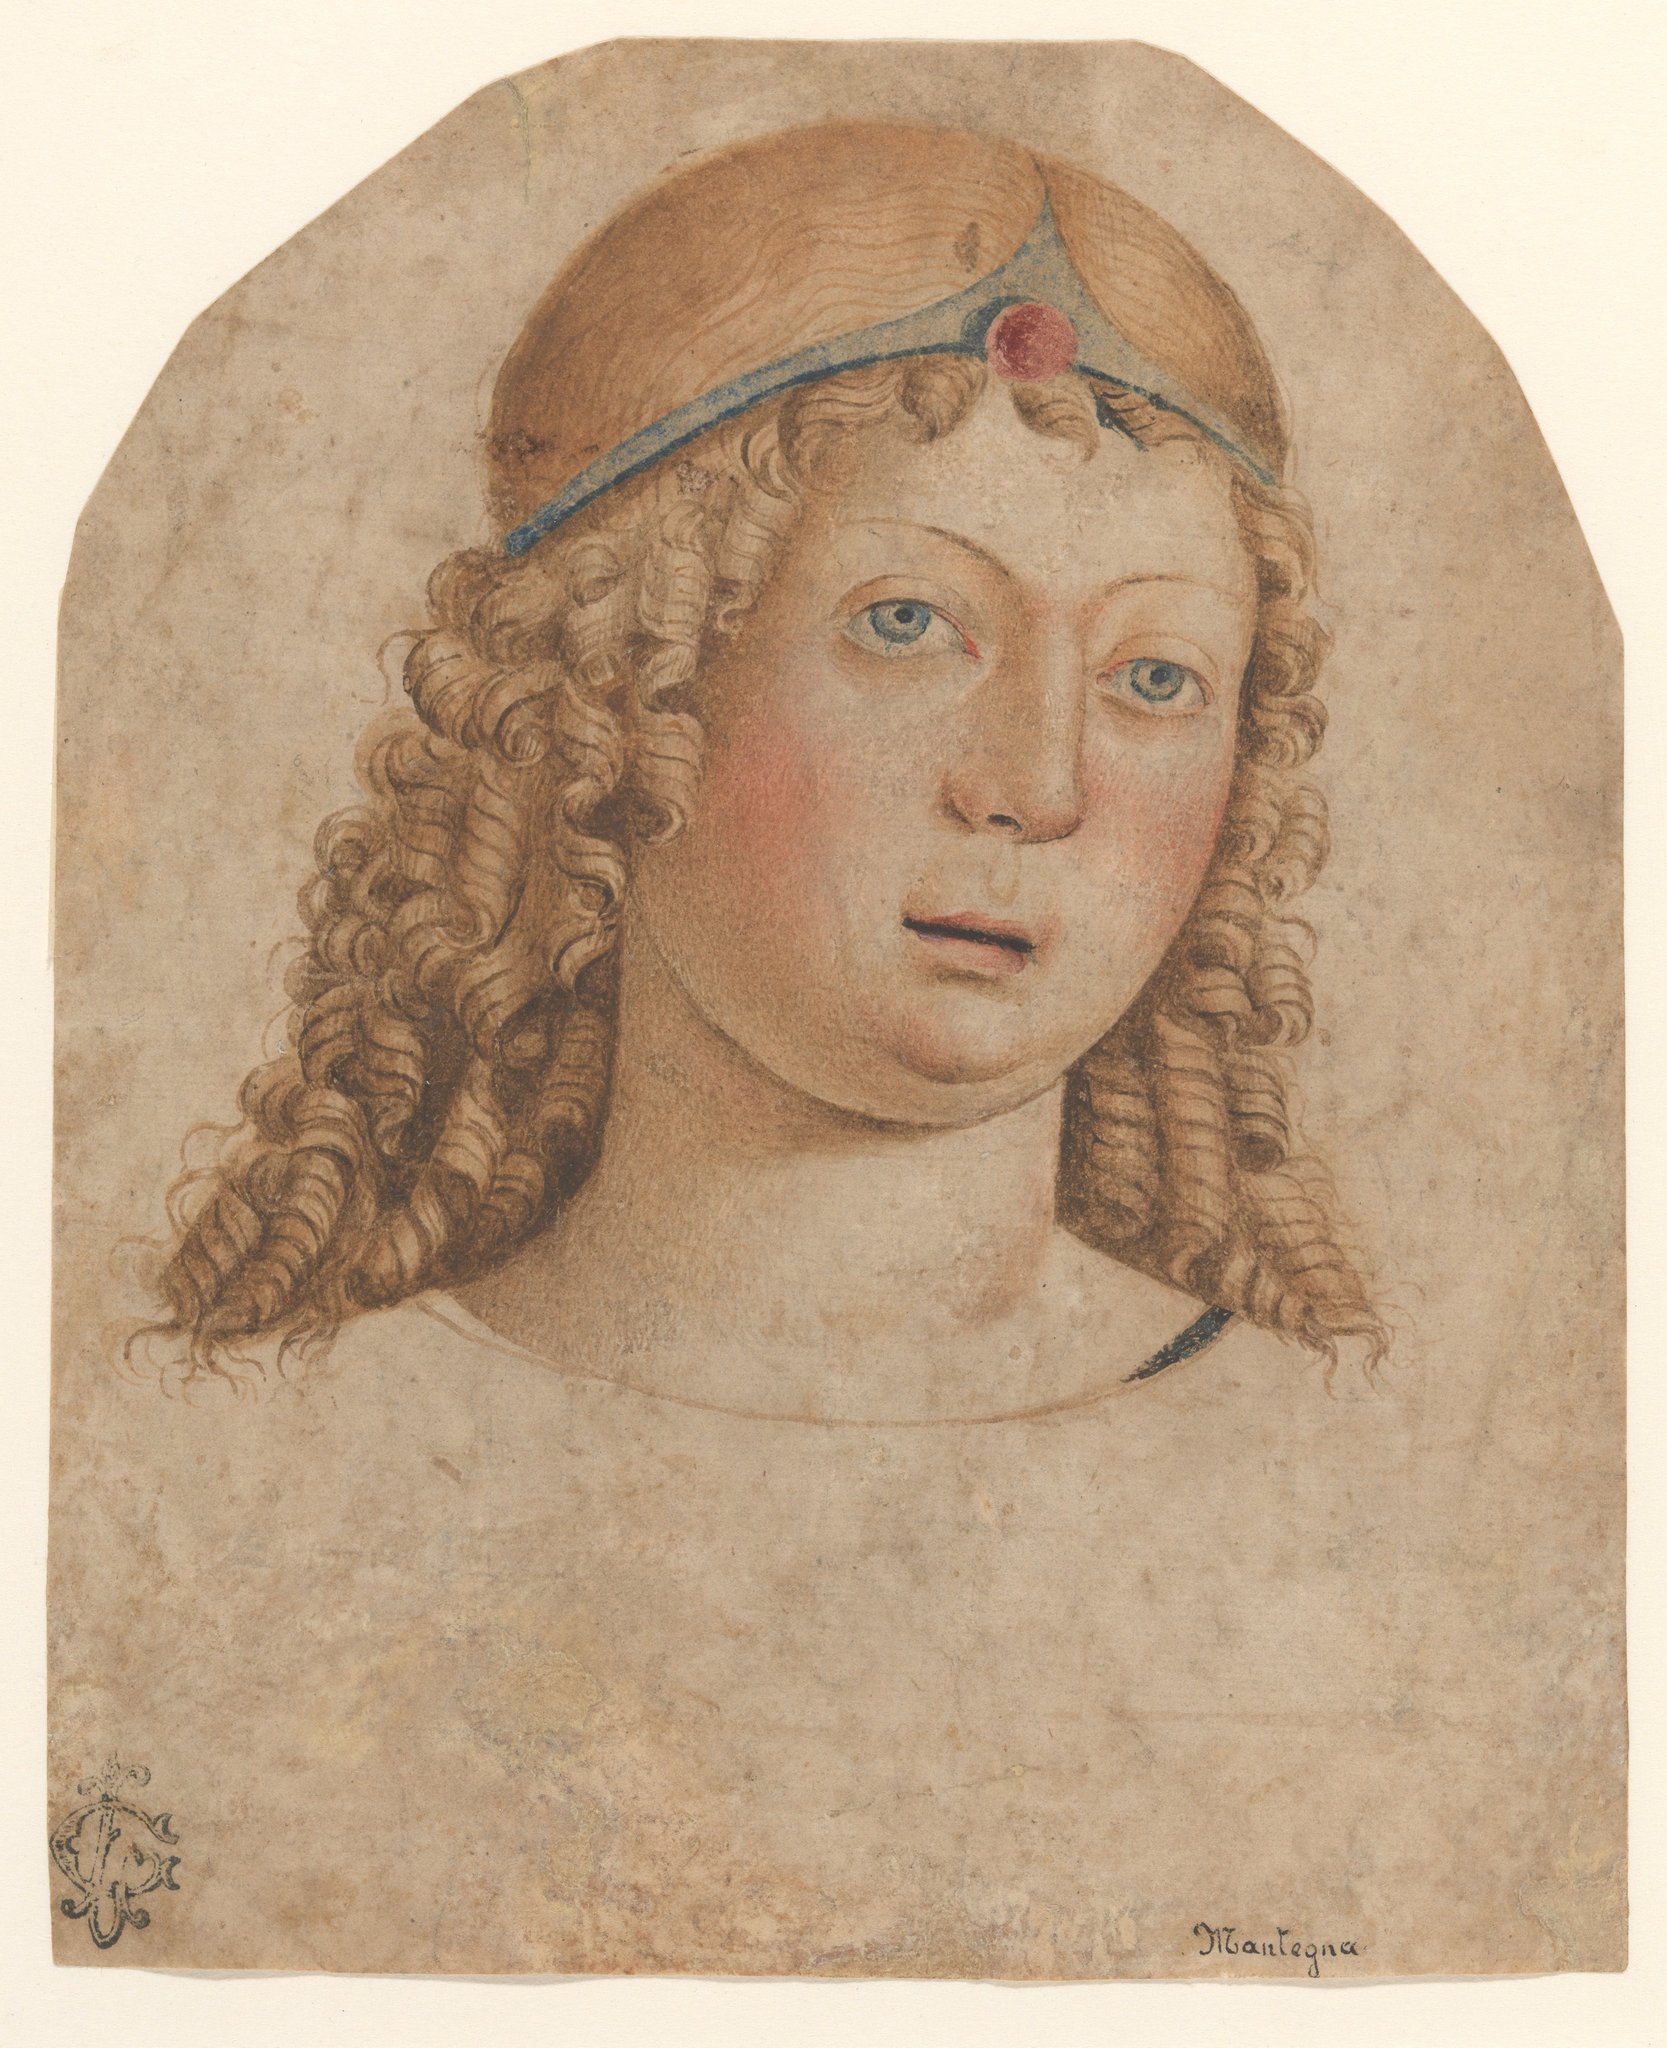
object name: drawing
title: Head of a Youth with a Diadem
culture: italian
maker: cristoforo caselli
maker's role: artist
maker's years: 1460-1521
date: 1467-1533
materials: ink, paper, watercolor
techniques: pen, tinting, wash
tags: boys